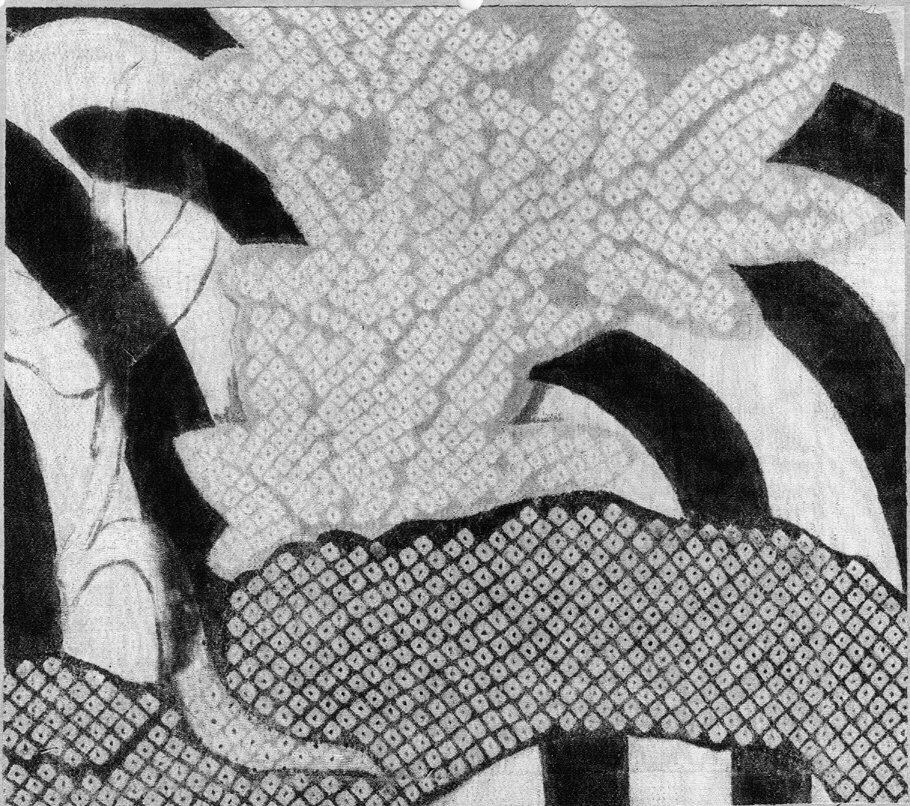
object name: piece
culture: japanese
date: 1601-1800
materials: silk